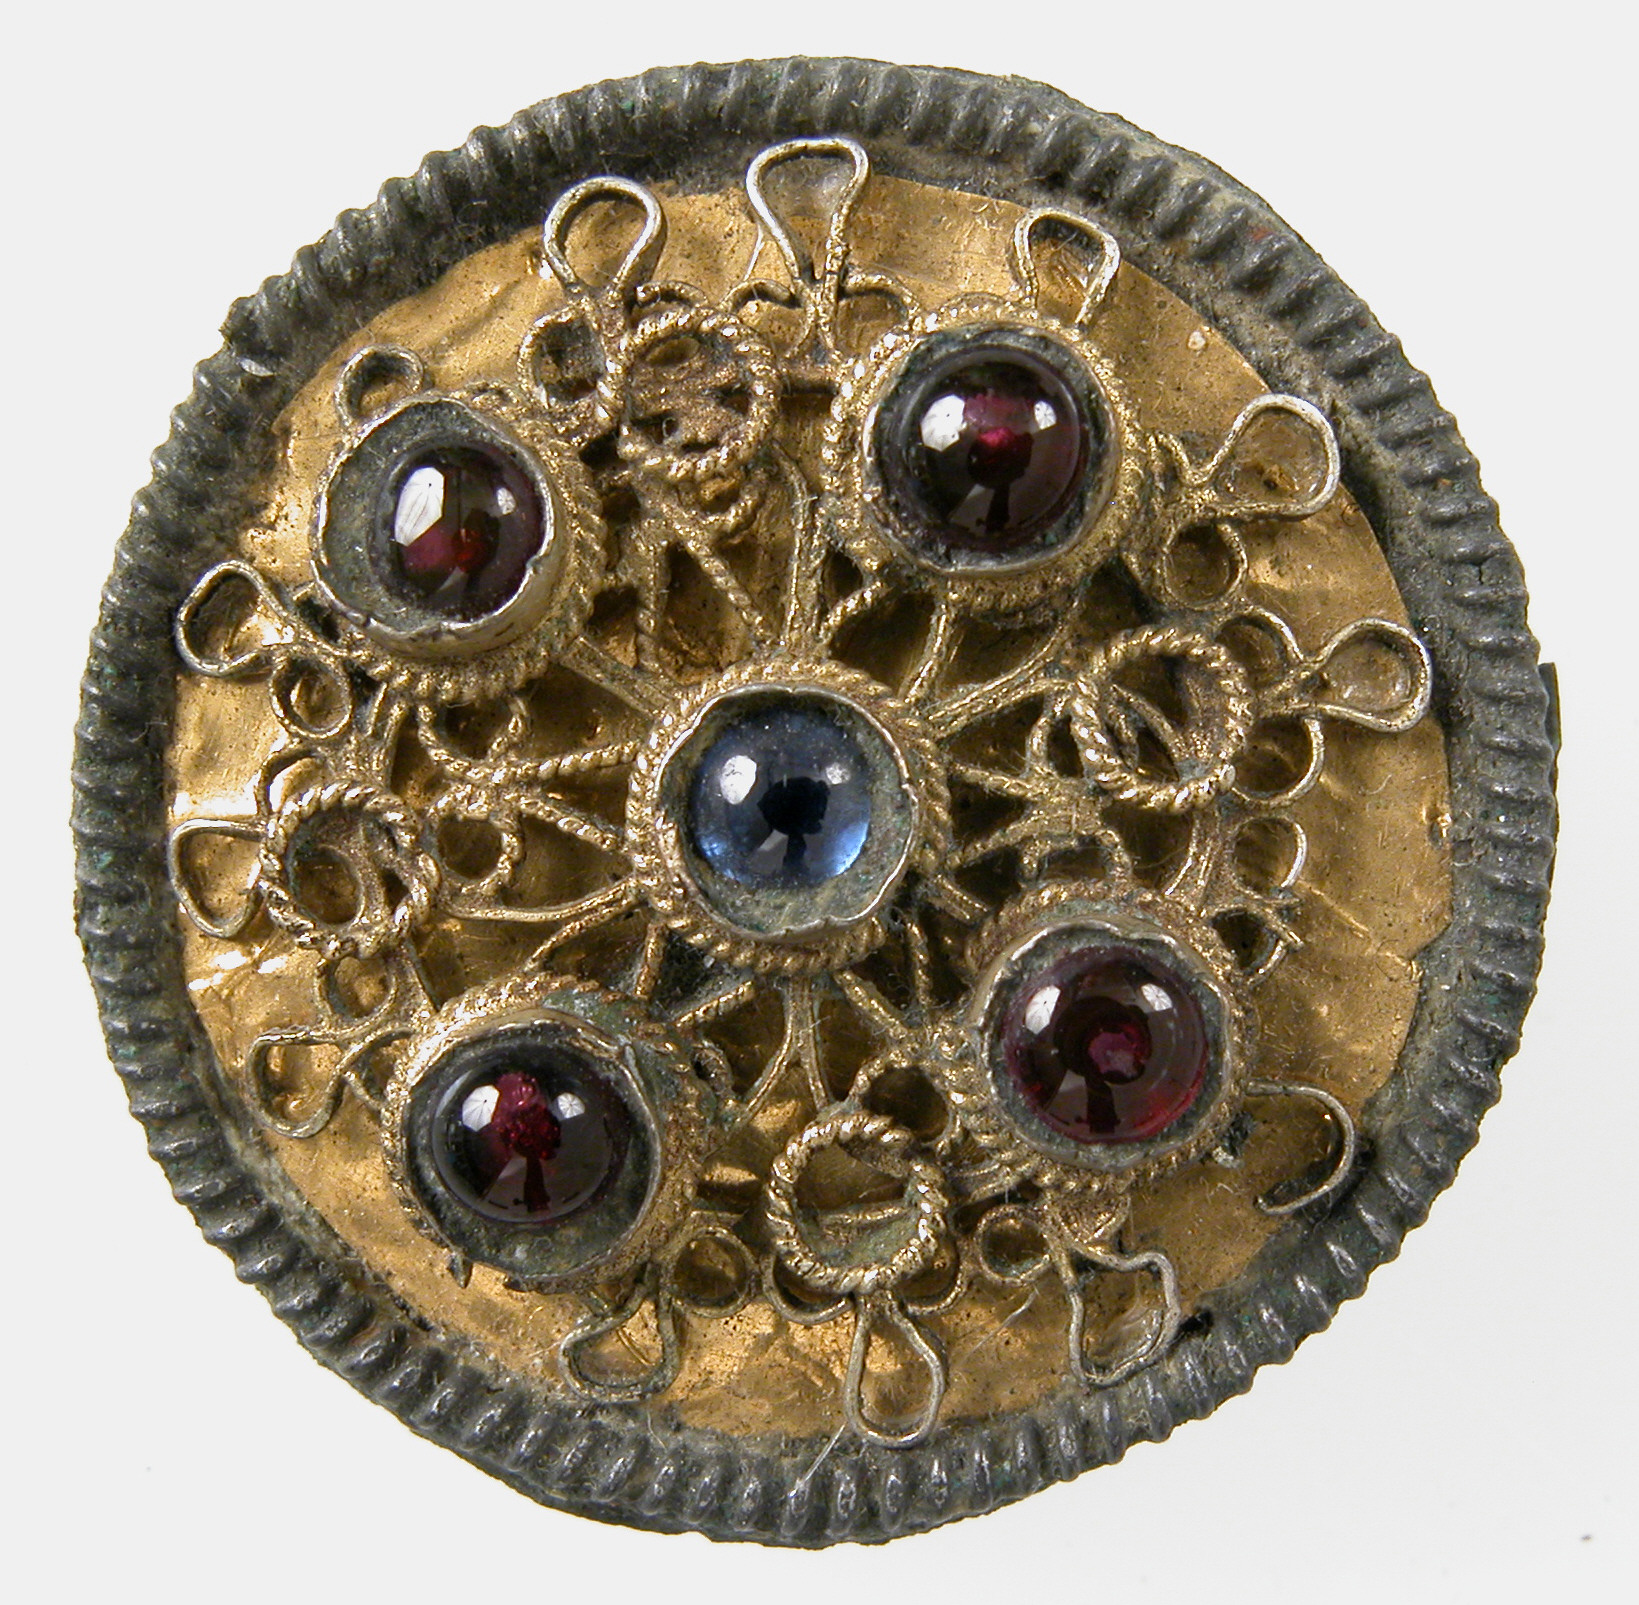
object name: brooch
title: Disk Brooch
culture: frankish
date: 601-700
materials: copper alloy, garnet, gold, gemstone